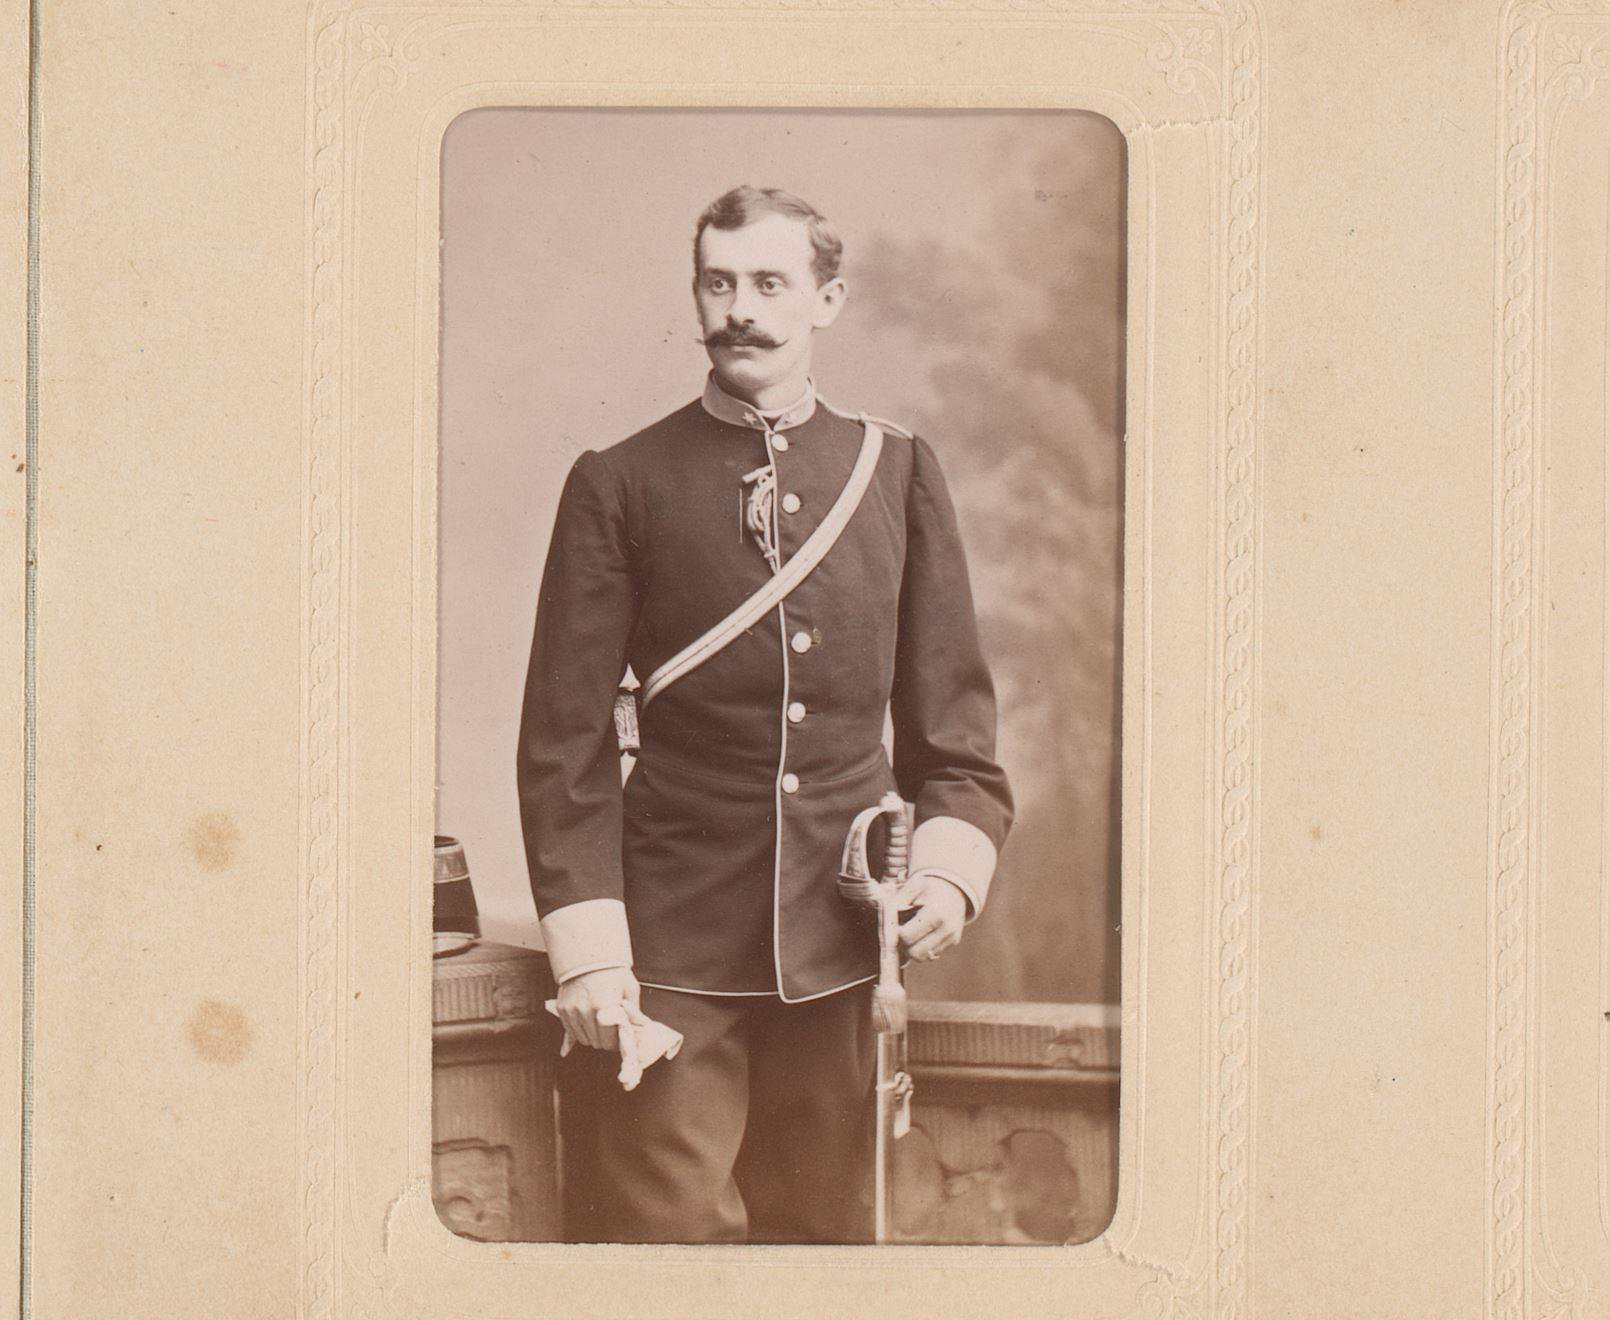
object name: album leaf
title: Portret van een staande man in militair uniform met zwaard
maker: hynek fiedler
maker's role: painter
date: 1860-1900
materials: cardboard, photographic support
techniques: albumen print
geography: prague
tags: historical persons, hacking and thrusting weapons: sword, (military) uniforms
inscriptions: inscription: ‘PRAHA/ VÁCL. NÁM./ cis 24 nové/ Atelier H. Fiedler/ PRAG/ WENZELS-PLATZ/ No 24 NEU.’